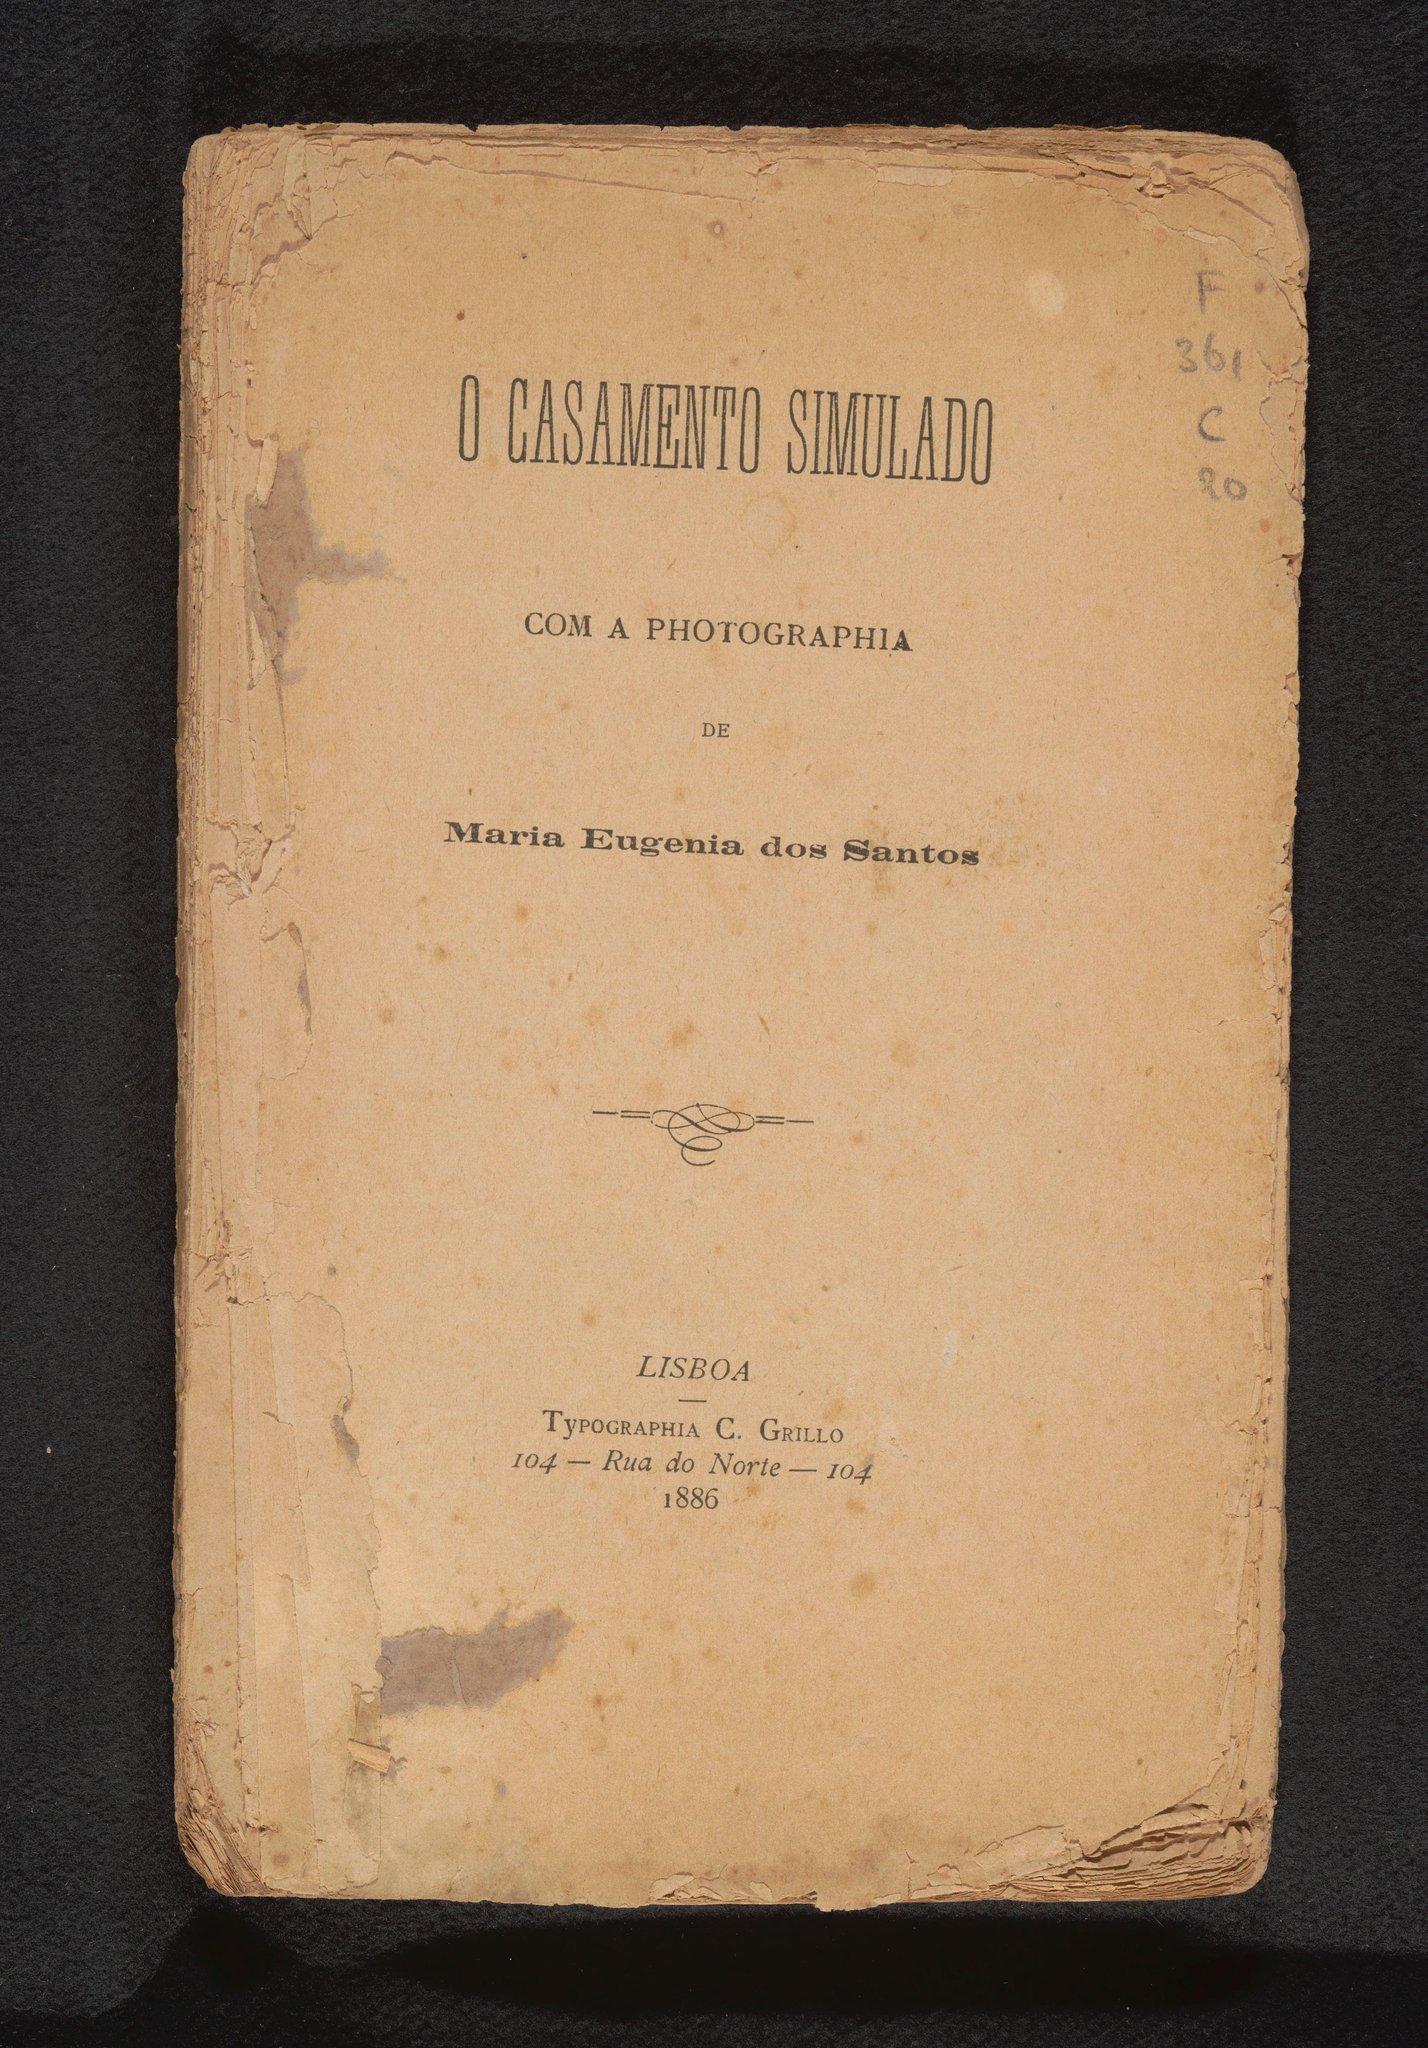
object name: book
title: O casamento simulado com a photographia de Maria Eugenia dos Santos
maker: c. grillo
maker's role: typograaf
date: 1886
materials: paper, photographic support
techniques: albumen print, printing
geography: lisbon